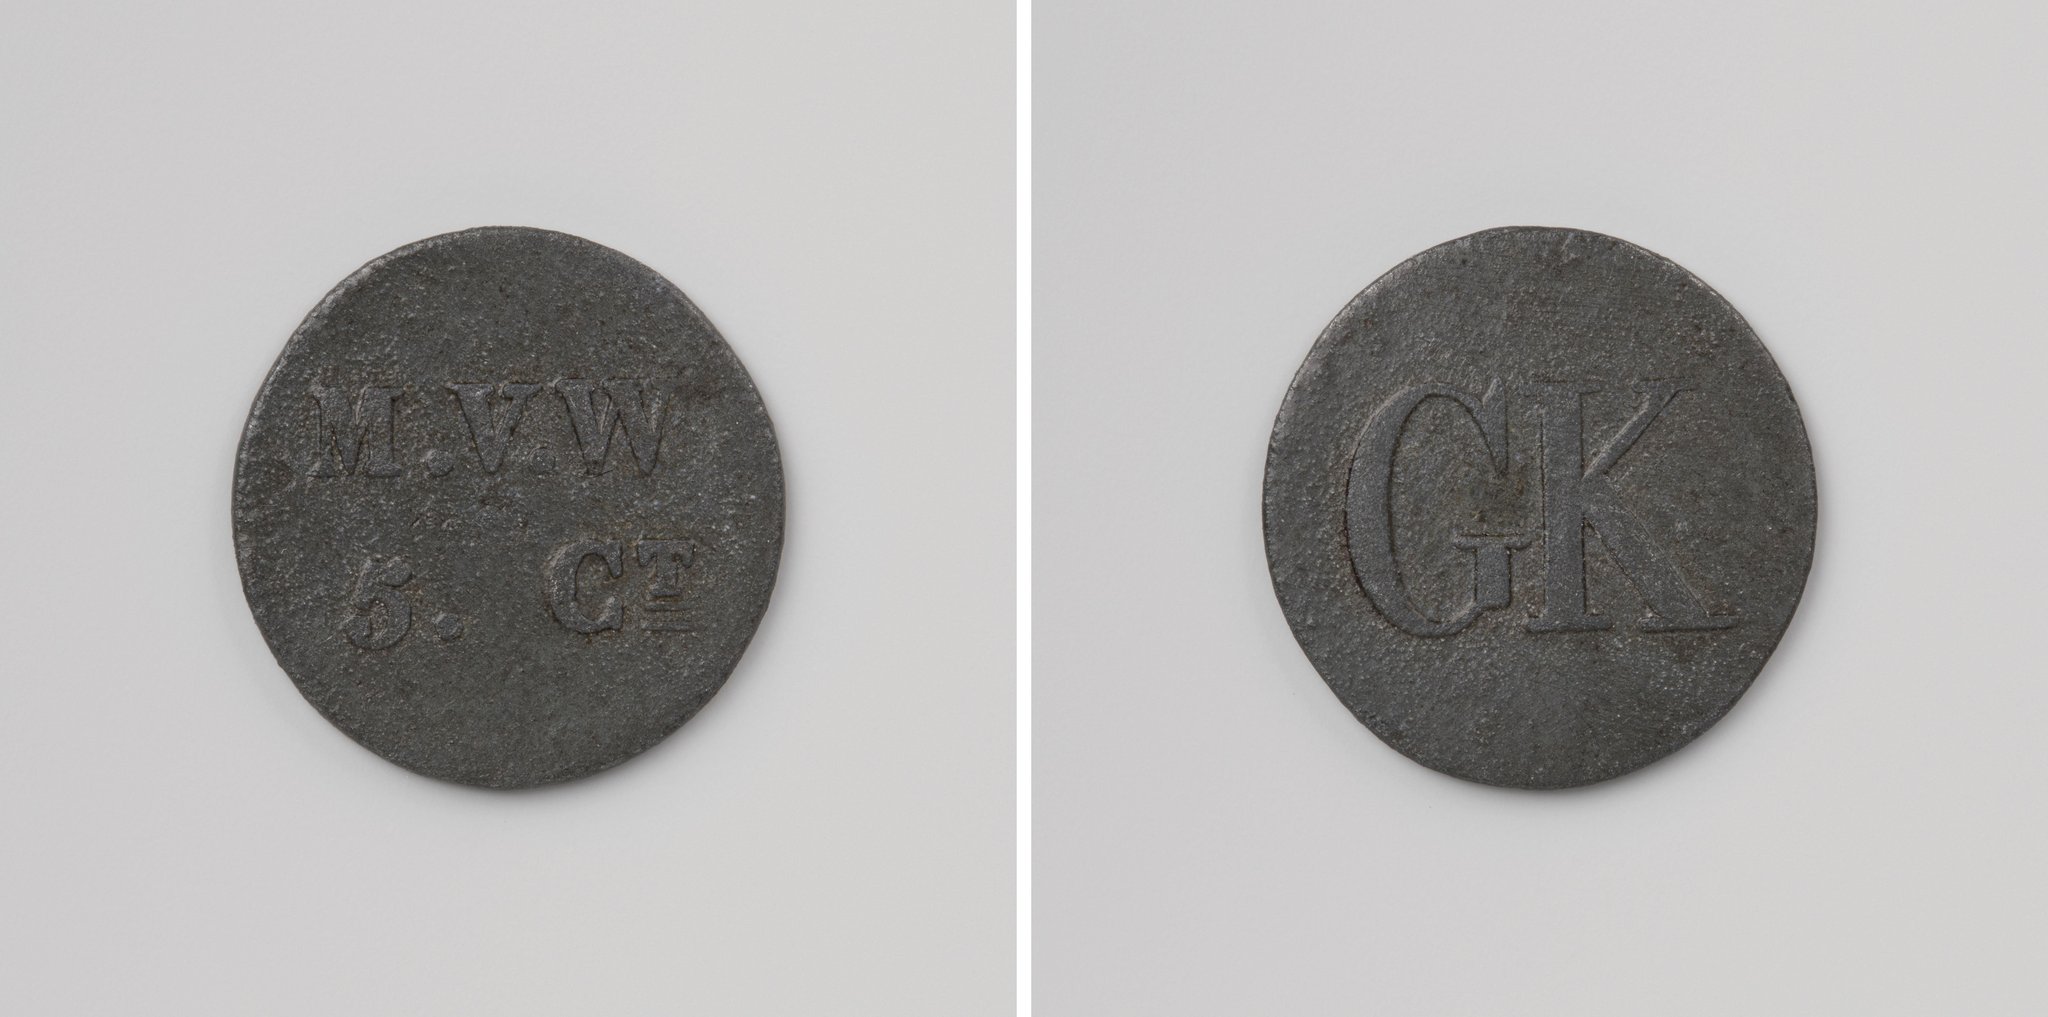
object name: monetary token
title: Huismunt geslagen op last van de Maatschappij van Weldadigheid ter waarde van vijf cent, ten behoeve van de Gewone Koloniën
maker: Anonymous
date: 1818-1859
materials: zinc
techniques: striking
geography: netherlands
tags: maatschappij van weldadigheid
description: Zinken munt. Voorzijde: opschrift boven waardeaanduiding. Keerzijde: opschrift G en K.